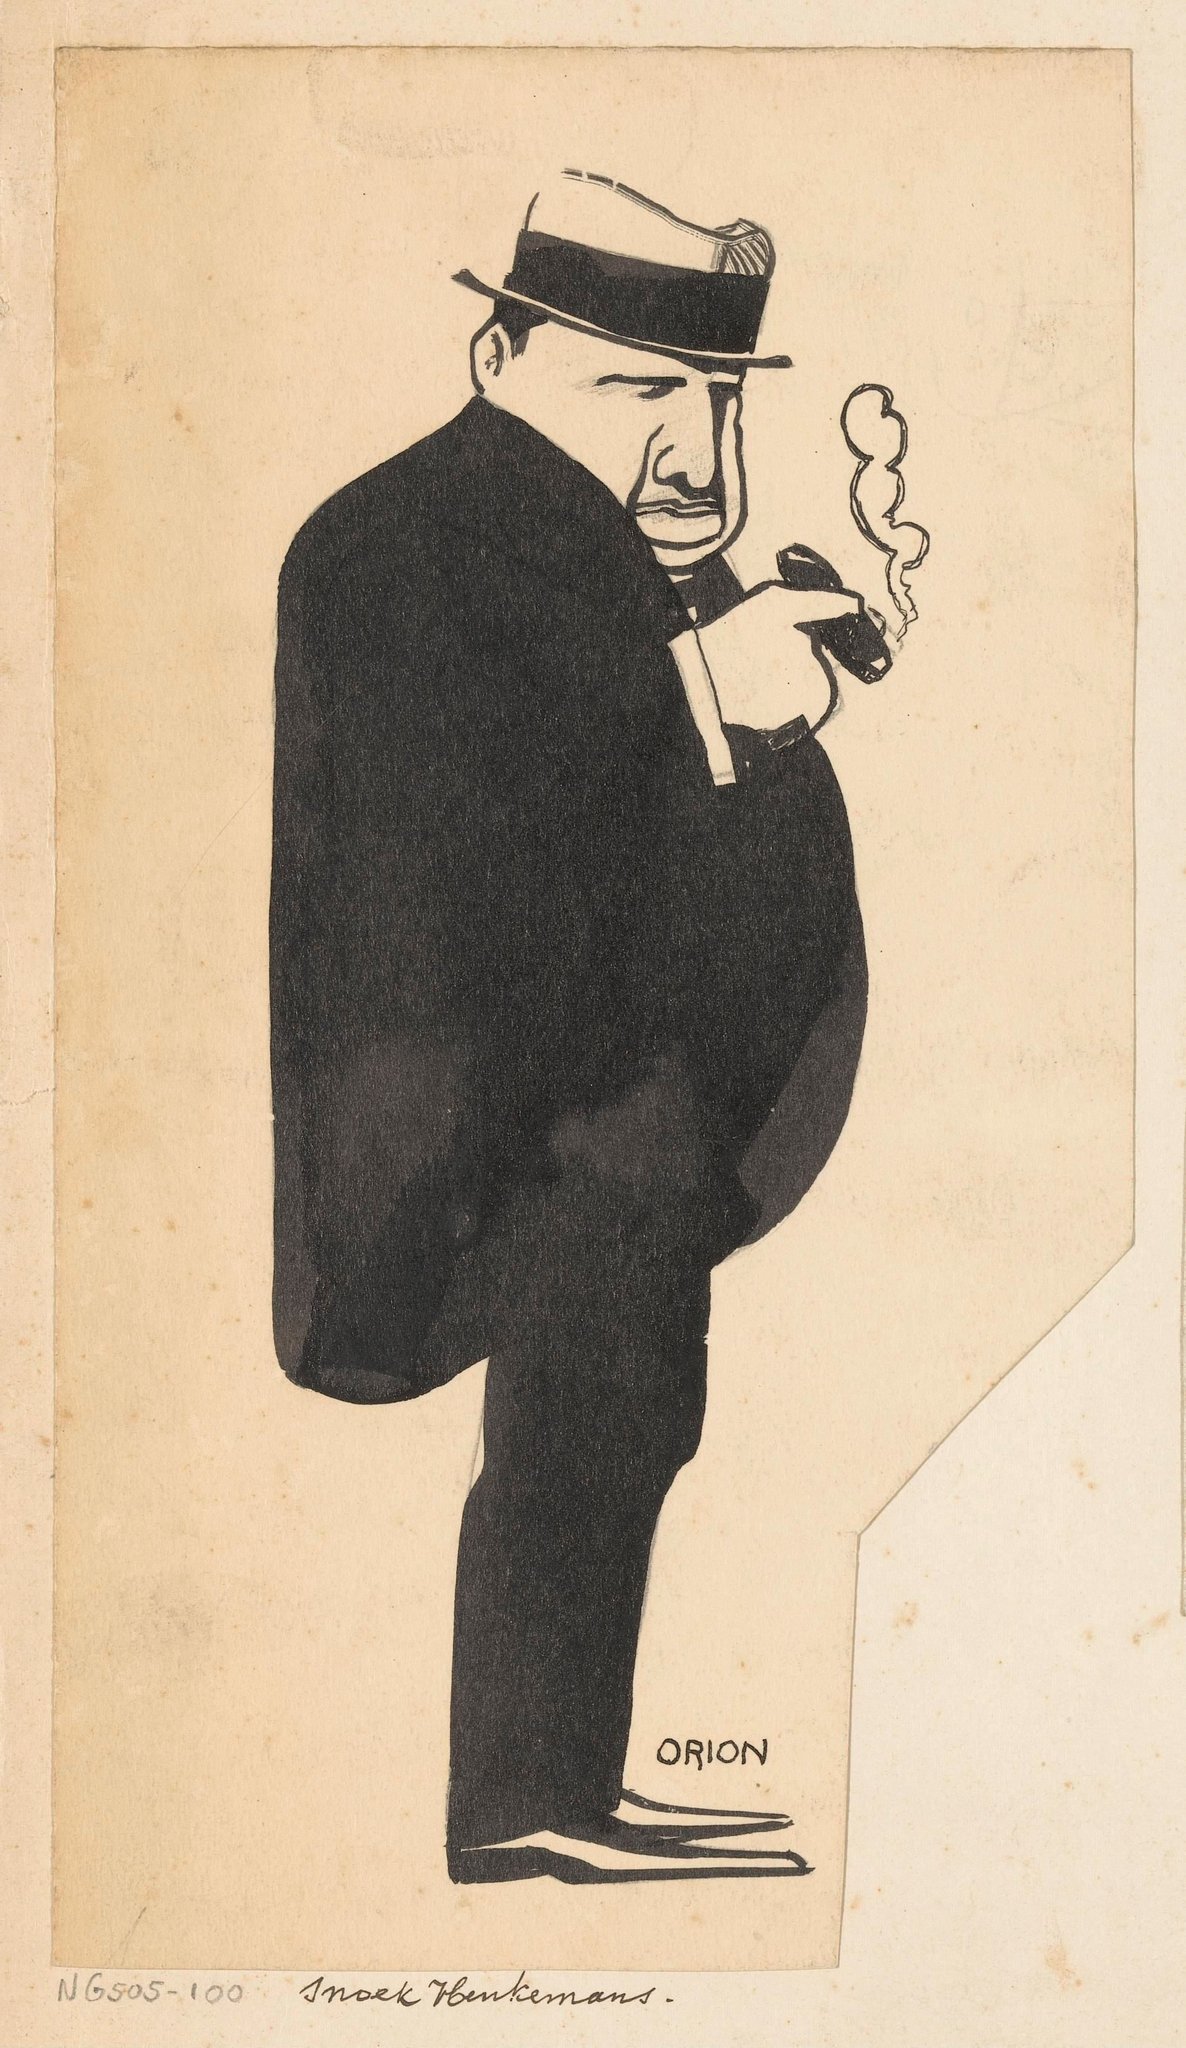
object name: drawing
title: Leden der oude garde / Snoek Henkemans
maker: patricq kroon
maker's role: draughtsman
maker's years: 1862-1941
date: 1909-1933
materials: ink, paper, pencil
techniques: brush, pen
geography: netherlands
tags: politician, caricatures (human types), historical persons, politician, e.g. party leader, political caricatures and satires, netherlands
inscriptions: inscription: ‘Leden der oude garde’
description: Karikatuur van de CHU politicus Johan Reinhardt Snoeck Henkemans. Staande met sigaar. Tekening op een blad geplakt samen met twee andere karikaturen. Ontwerp voor een politieke spotprent.